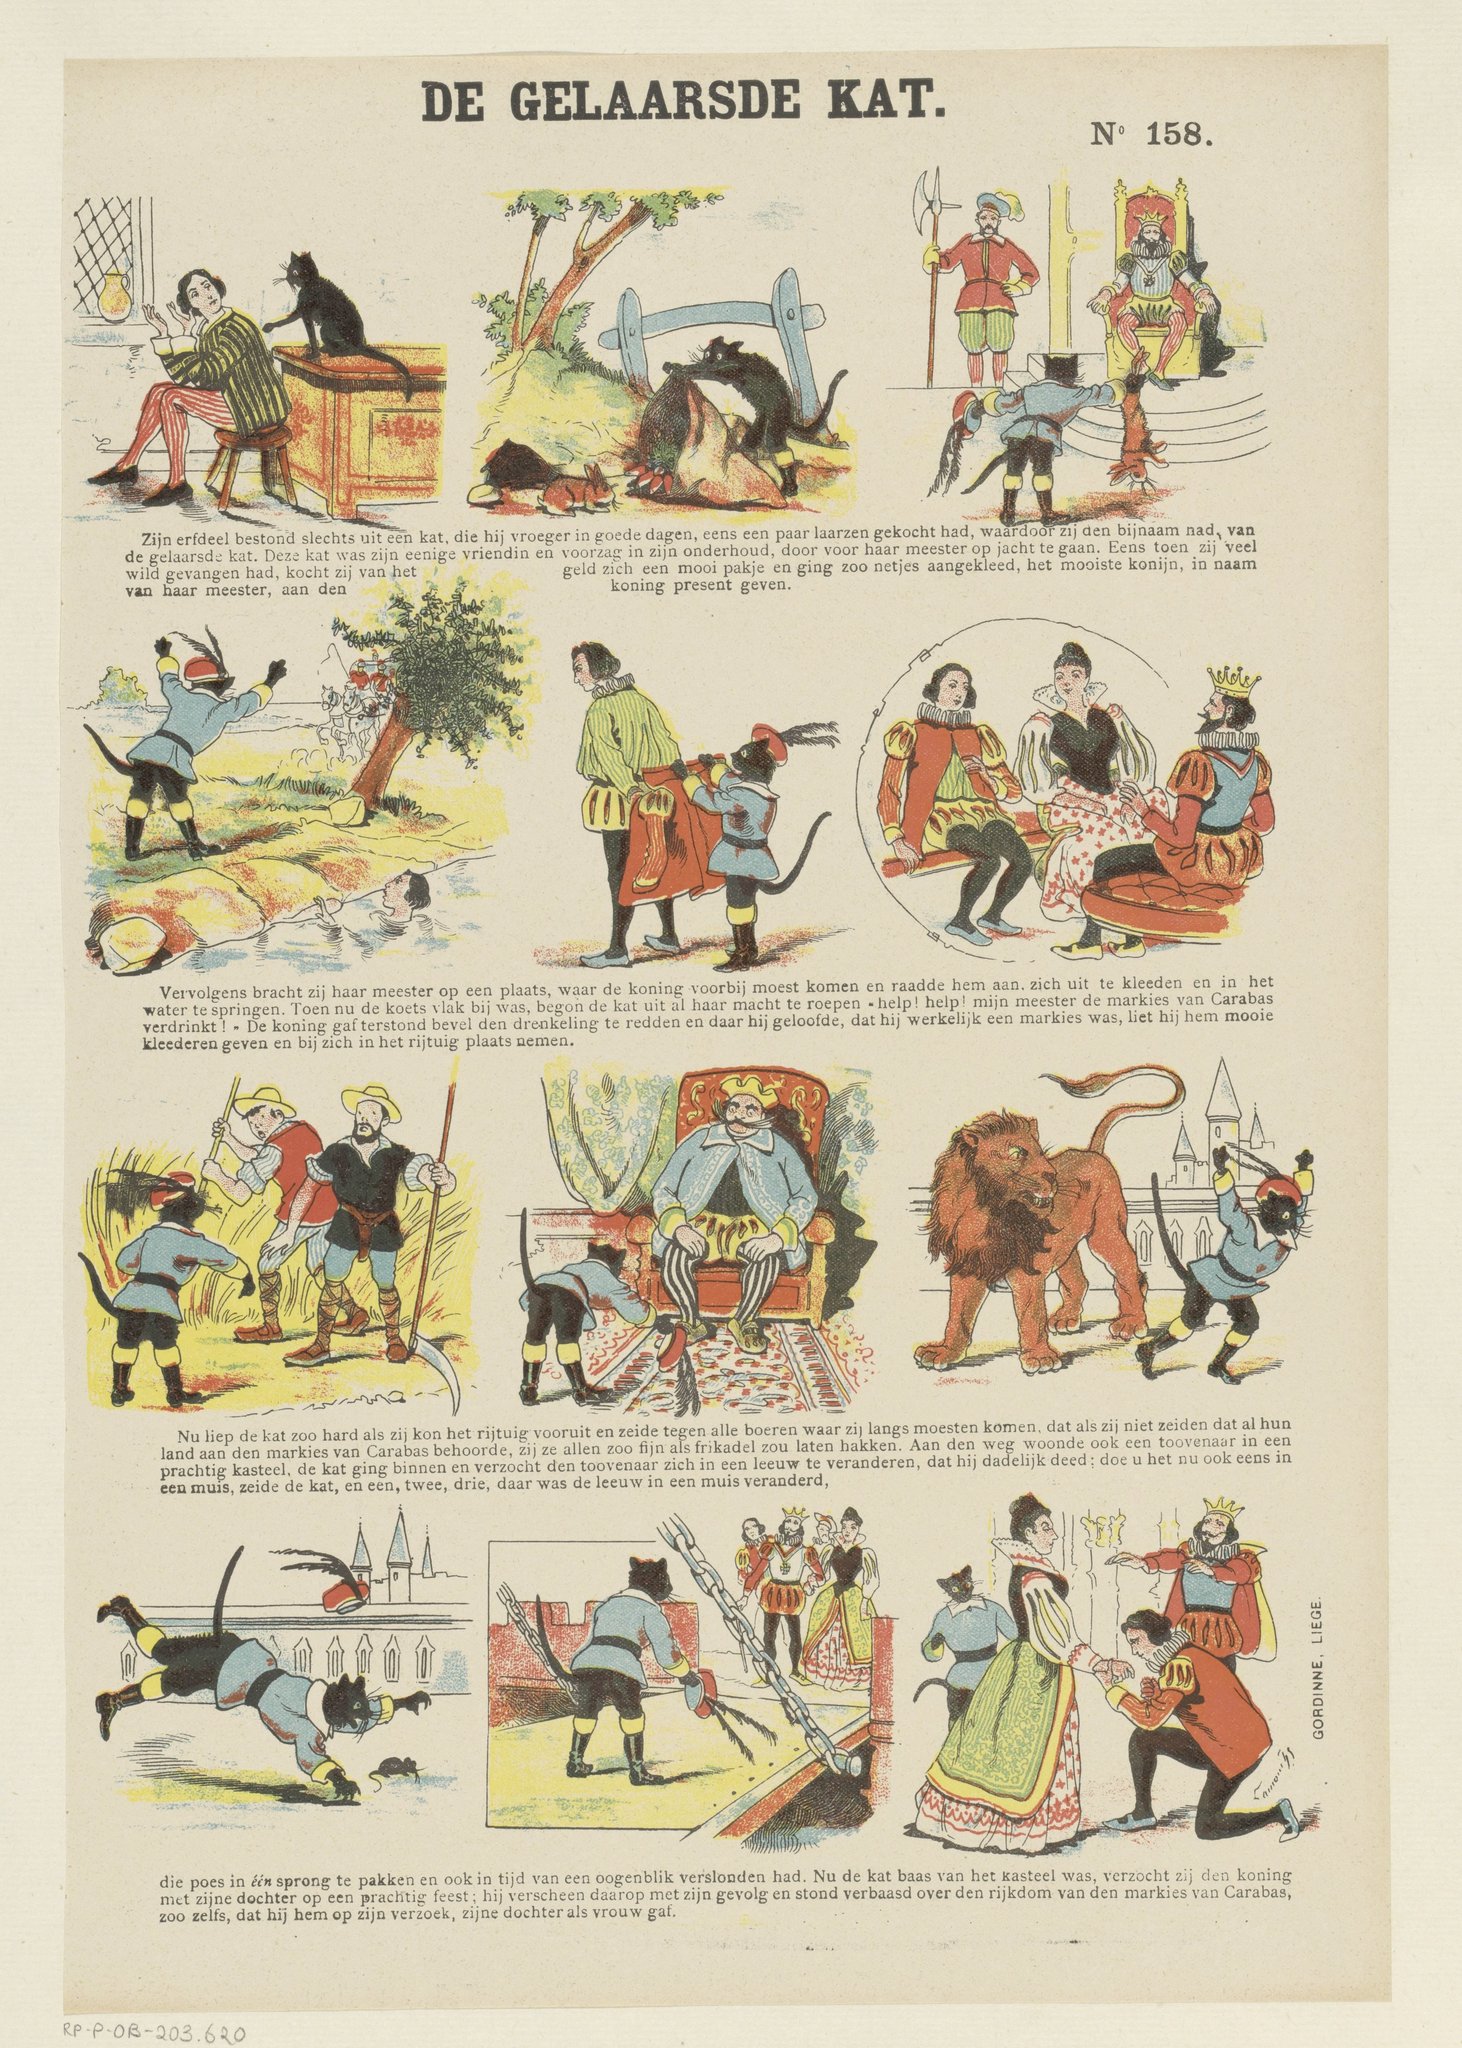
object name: print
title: De gelaarsde kat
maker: lamouche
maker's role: print maker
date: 1894-1959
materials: paper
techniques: lithograph, letterpress printing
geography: liège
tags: tales and fairy tales: puss in boots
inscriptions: collector's mark: Lugt 2760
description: Blad met 12 voorstellingen uit het sprookje van de gelaarsde kat. Onder elke afbeelding een onderschrift. Genummerd rechtsboven: No 158.